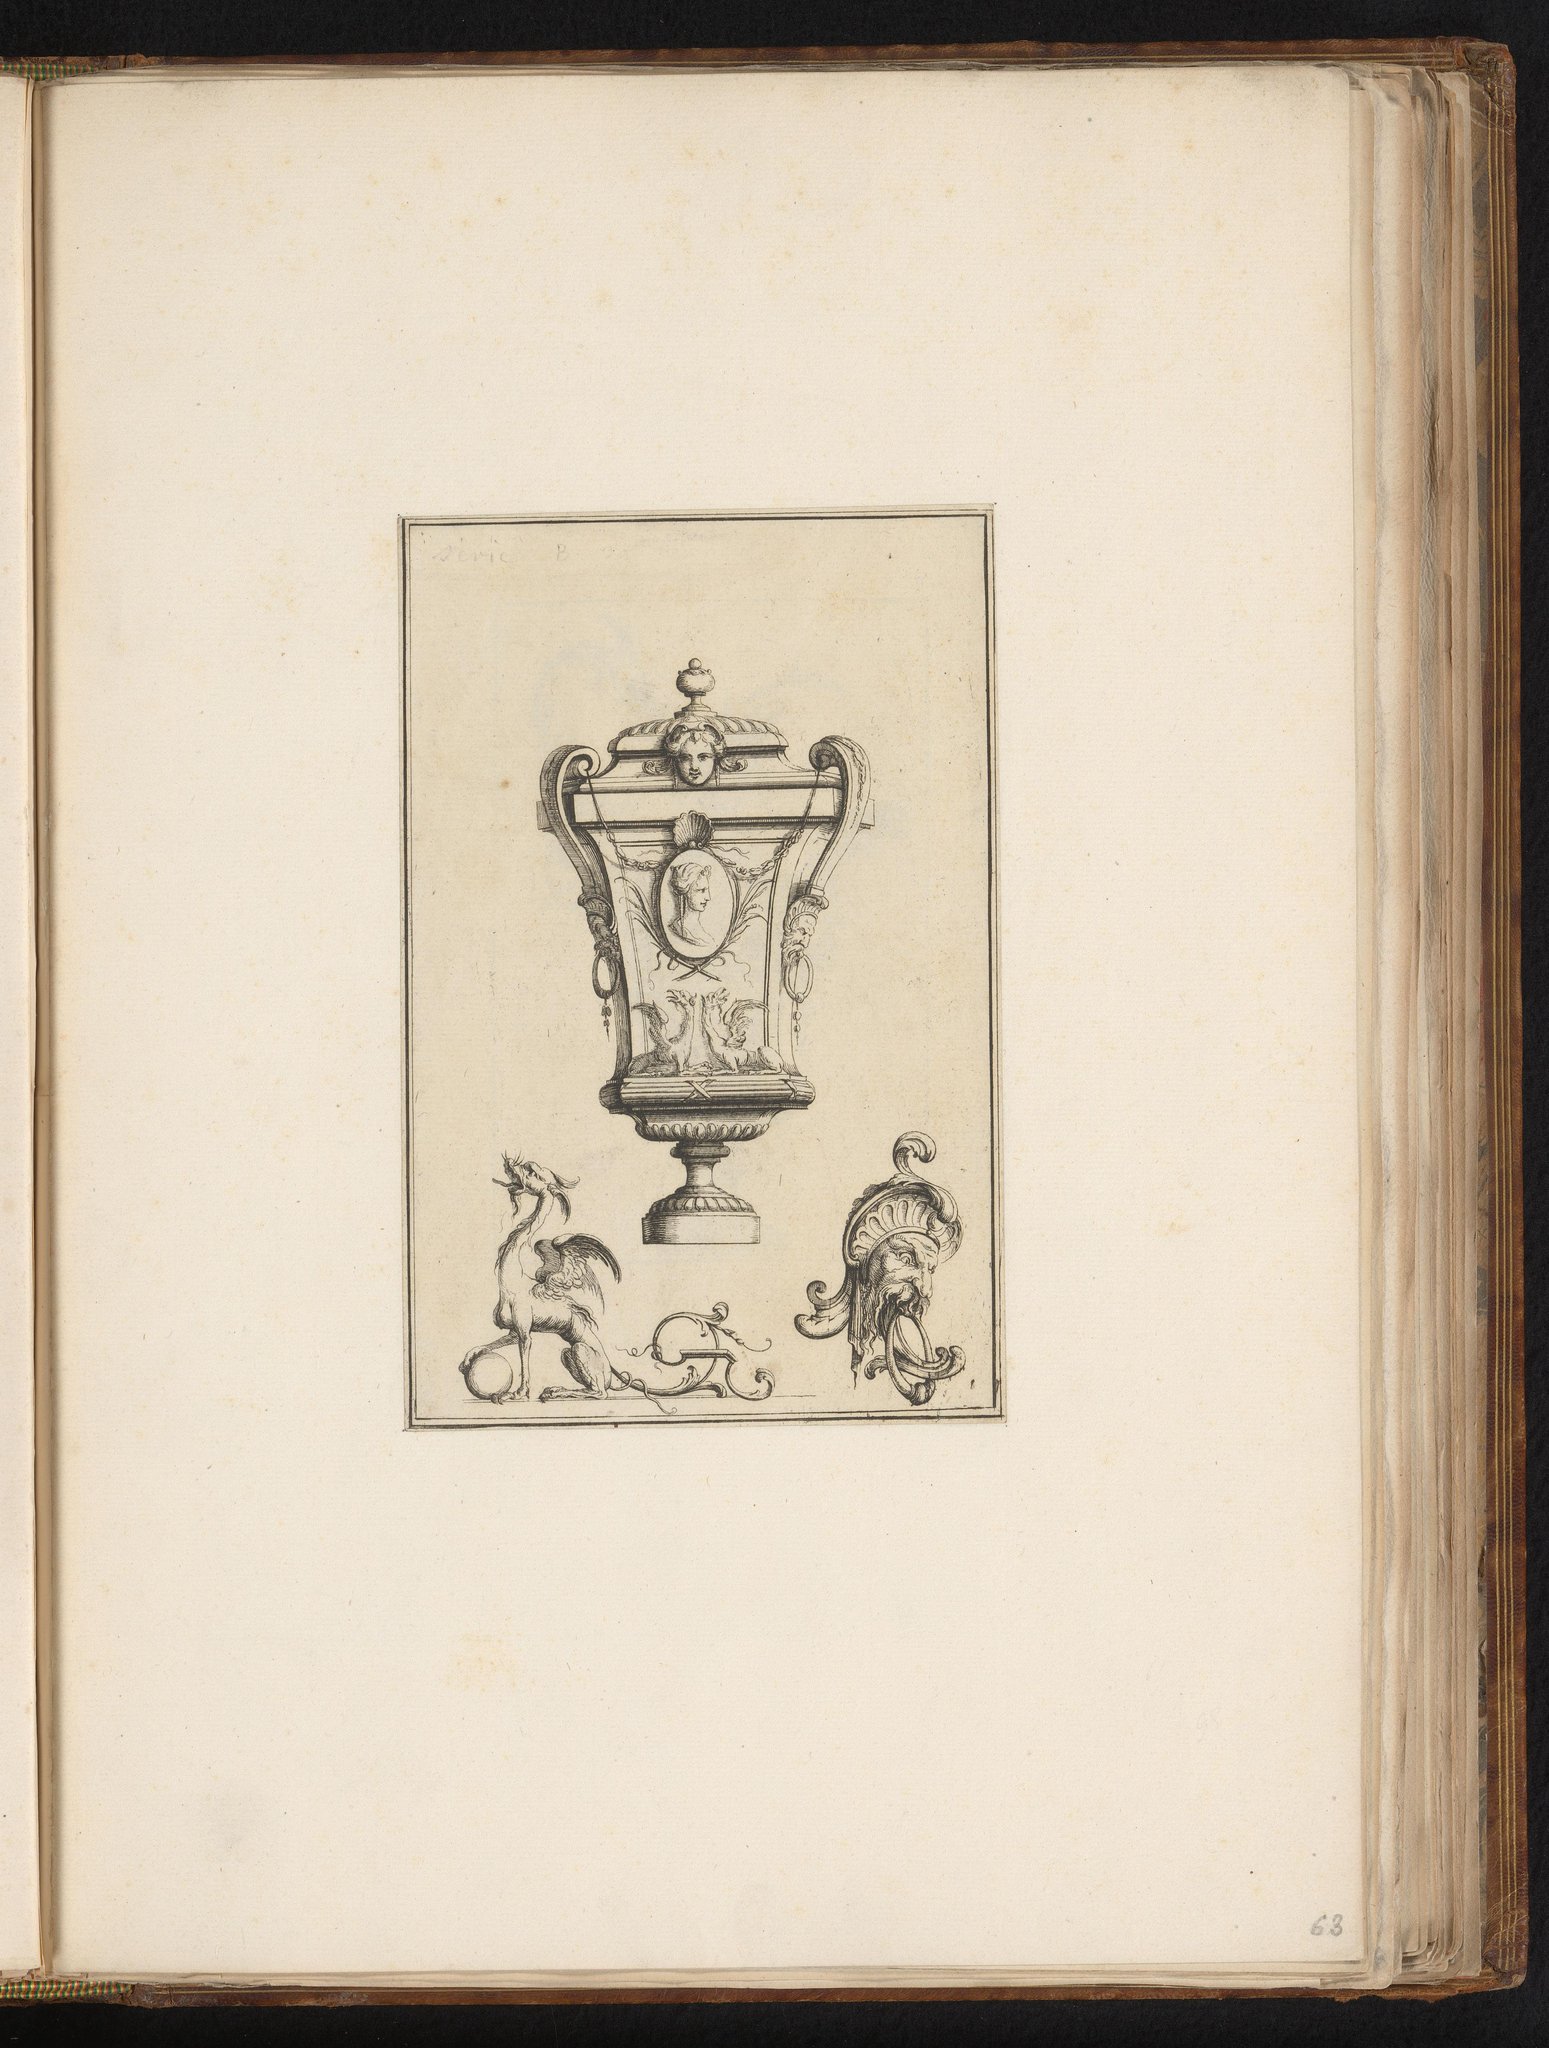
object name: print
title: Ontwerpen voor ornamenten met vazen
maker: honoré blanc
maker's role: print maker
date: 1682-1734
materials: paper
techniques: etching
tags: fabulous animals (sometimes wrongly called 'grotesques'); 'mostri' (ripa), vase ~ ornament, garden vase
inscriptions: collector's mark: Lugt 2228, collector's mark: Lugt 2760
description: Prent maakt deel uit van een serie van zes prenten.